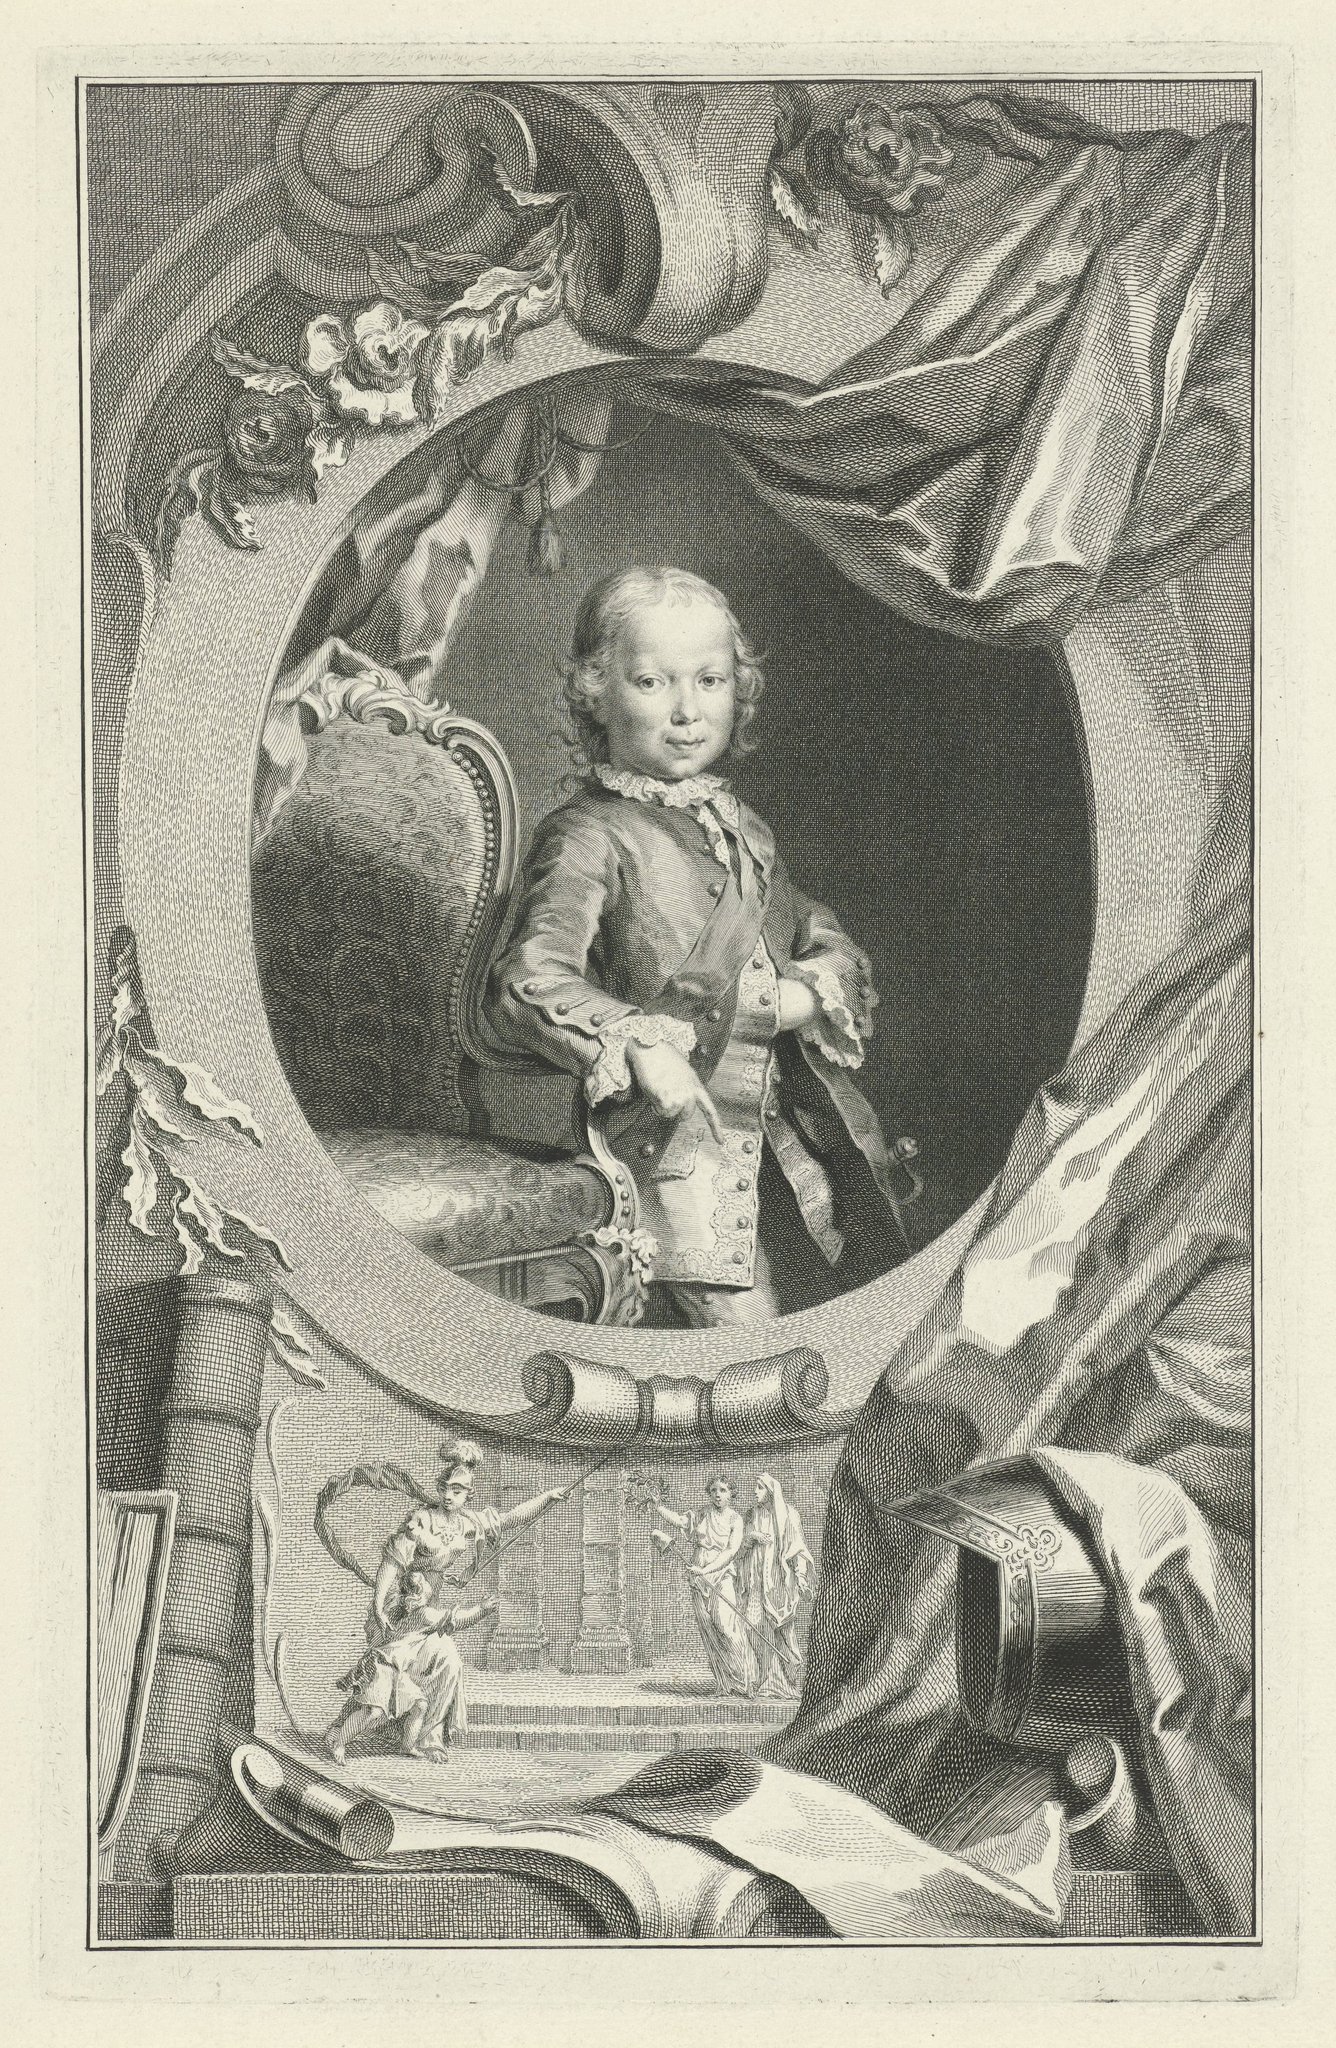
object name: print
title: Portret van Willem V, prins van Oranje-Nassau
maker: jacob houbraken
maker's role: draughtsman, print maker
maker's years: 1698-1780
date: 1752-1754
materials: paper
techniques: engraving, etching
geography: amsterdam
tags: the hague, william v (prince of orange)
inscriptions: collector's mark: Lugt 2228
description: Portret van Willem V, prins van Oranje-Nassau als zesjarige jongen, staand naast een stoel. Onder het portret een allegorische voorstelling waarin Minerva een jongen leidt naar vrouwfiguren met in hun hand een lauwerkrans en een vrijheidshoed op stok.